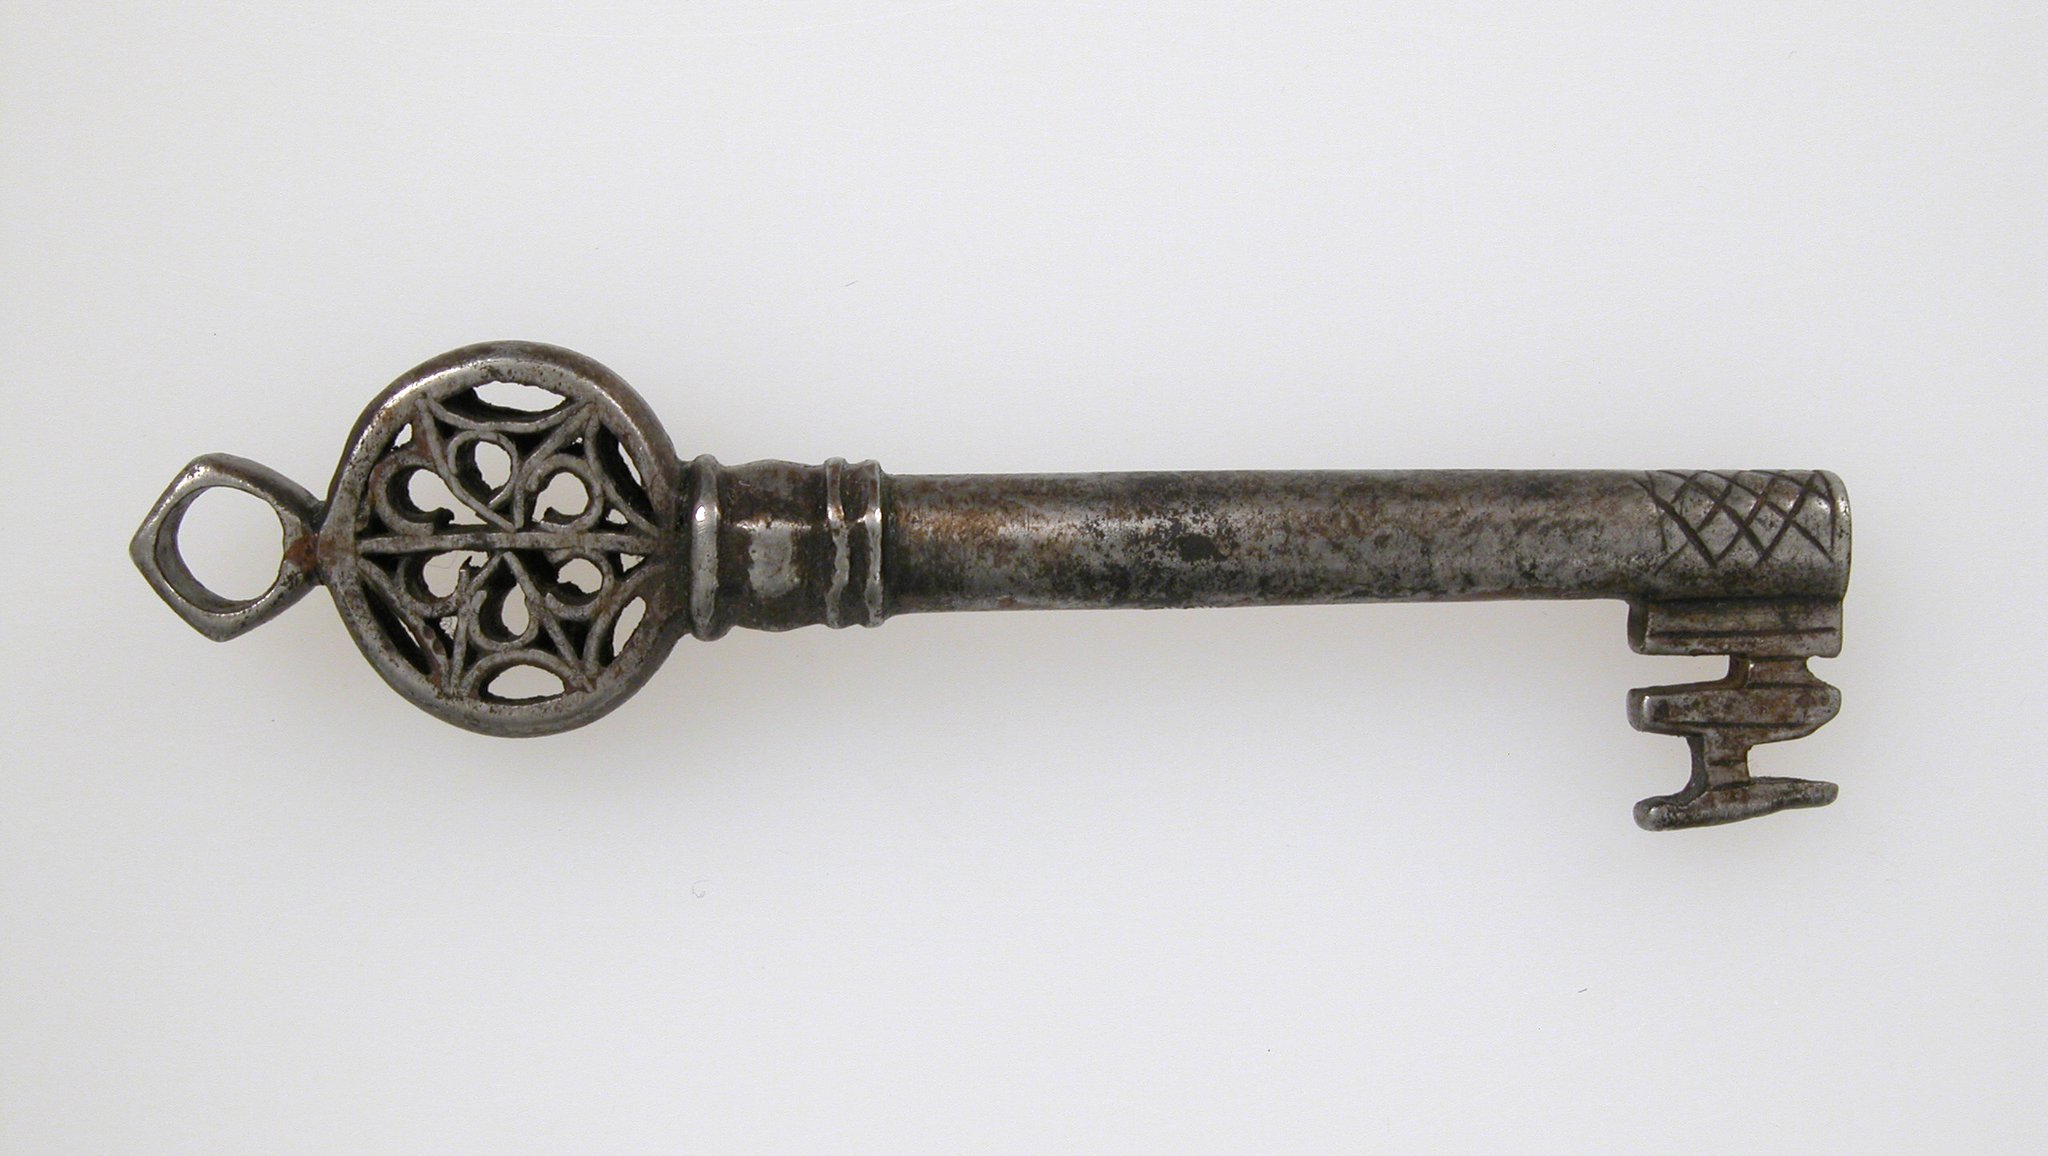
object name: key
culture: german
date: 1401-1500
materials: iron